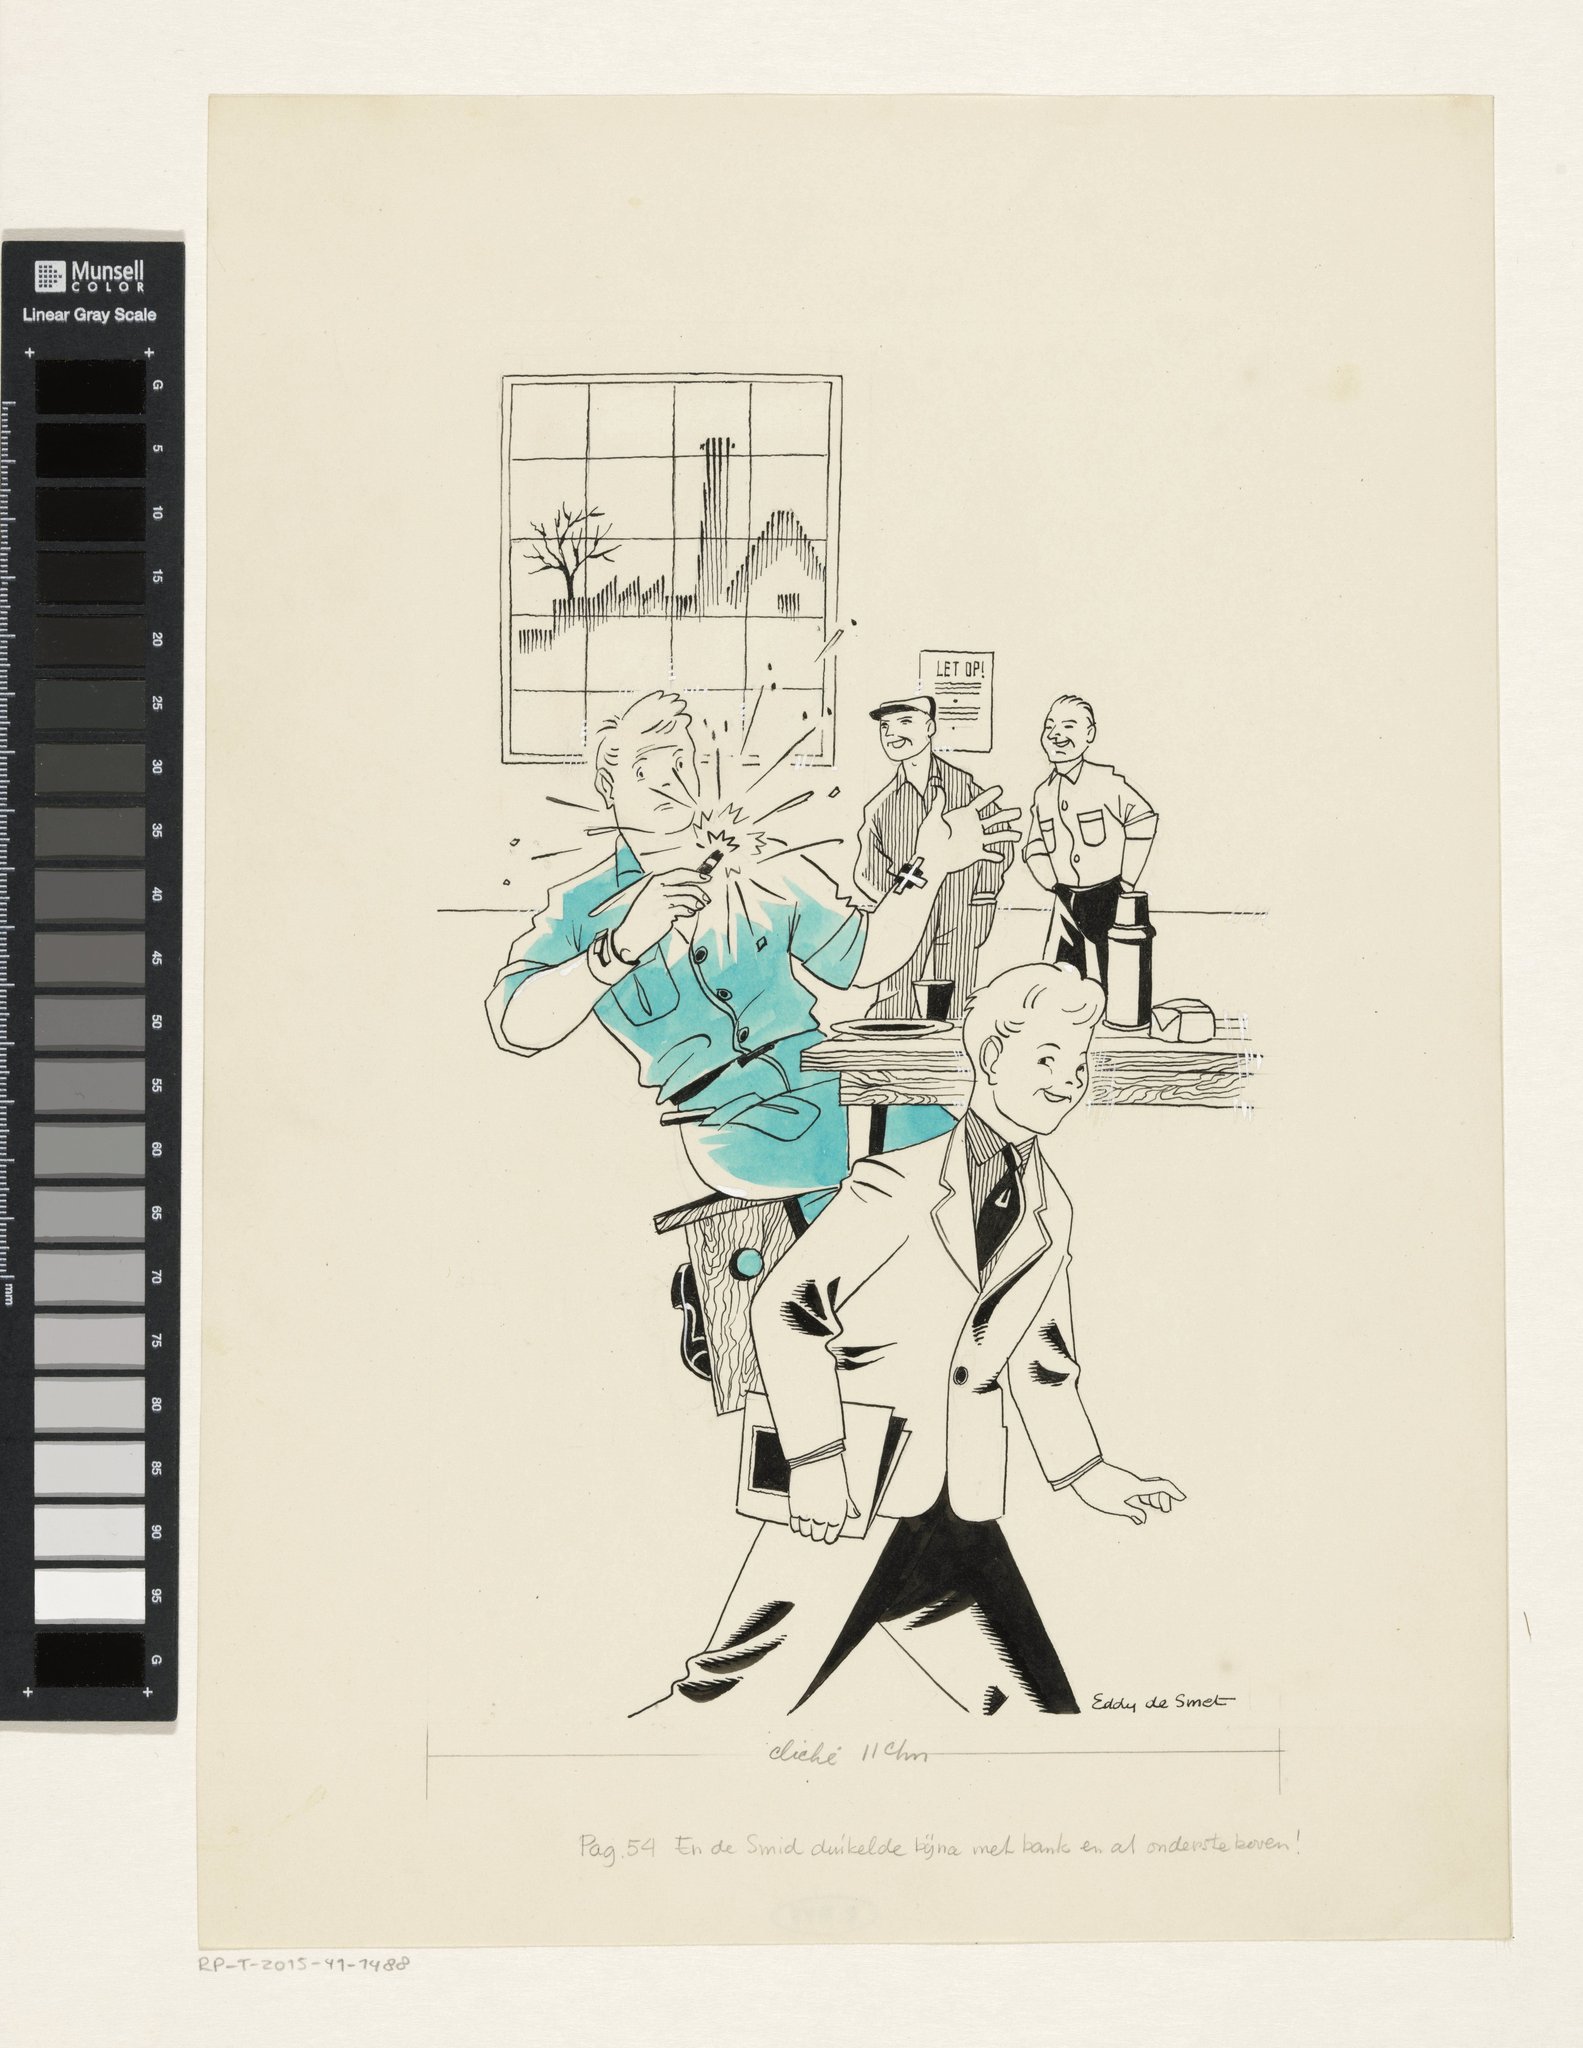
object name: drawing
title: Man valt van een kruk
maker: eddy de smet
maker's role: draughtsman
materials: paint, ink, paper, pencil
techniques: brush, pen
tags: falling, laid table: table-ware, table-decoration, etc.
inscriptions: :, signature: ‘Eddy de Smet’, annotation: ‘Pag. 54 En de Smid duikelde bijna met bank en al onderste boven!’, collector's mark: Lugt 2228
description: Een man in een overall zit op een kruk aan een tafel. Op tafel staan onder andere een thermosfles, glas en bord. De man heeft een voorwerp in de handen dat vonken in het rond sproeit. De man schrikt ervan en valt achterover van zijn kruk. In de achtergrond staan twee mannen te lachen. Op de voorgrond loopt Dikkie weg met een map onder zijn arm.